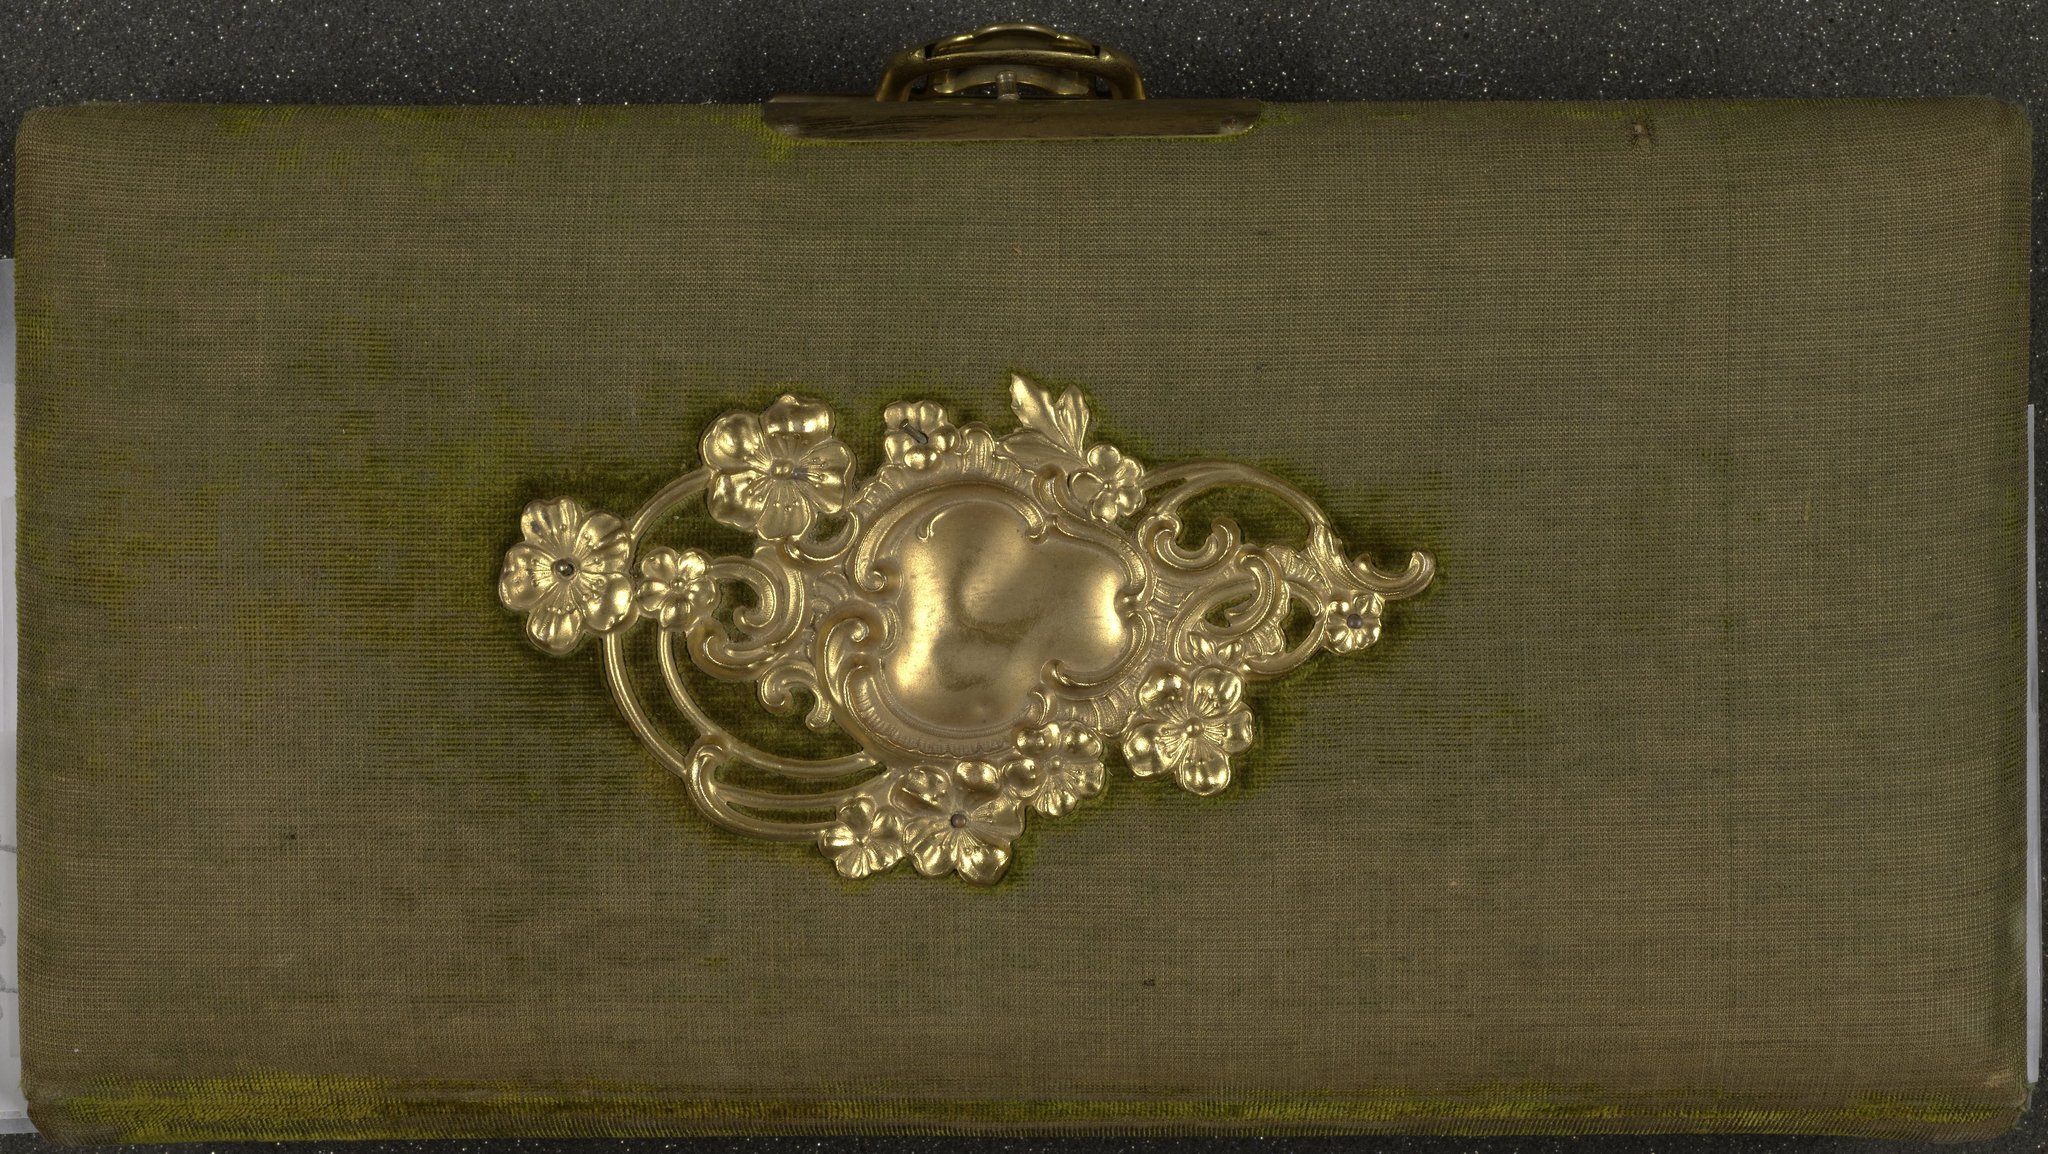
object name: photograph album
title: Familiealbum van de familie Kessler-De Lange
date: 1890-1910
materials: paper, photographic support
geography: the hague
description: Familiealbum van de familie Kessler-De Lange met 58 foto's.